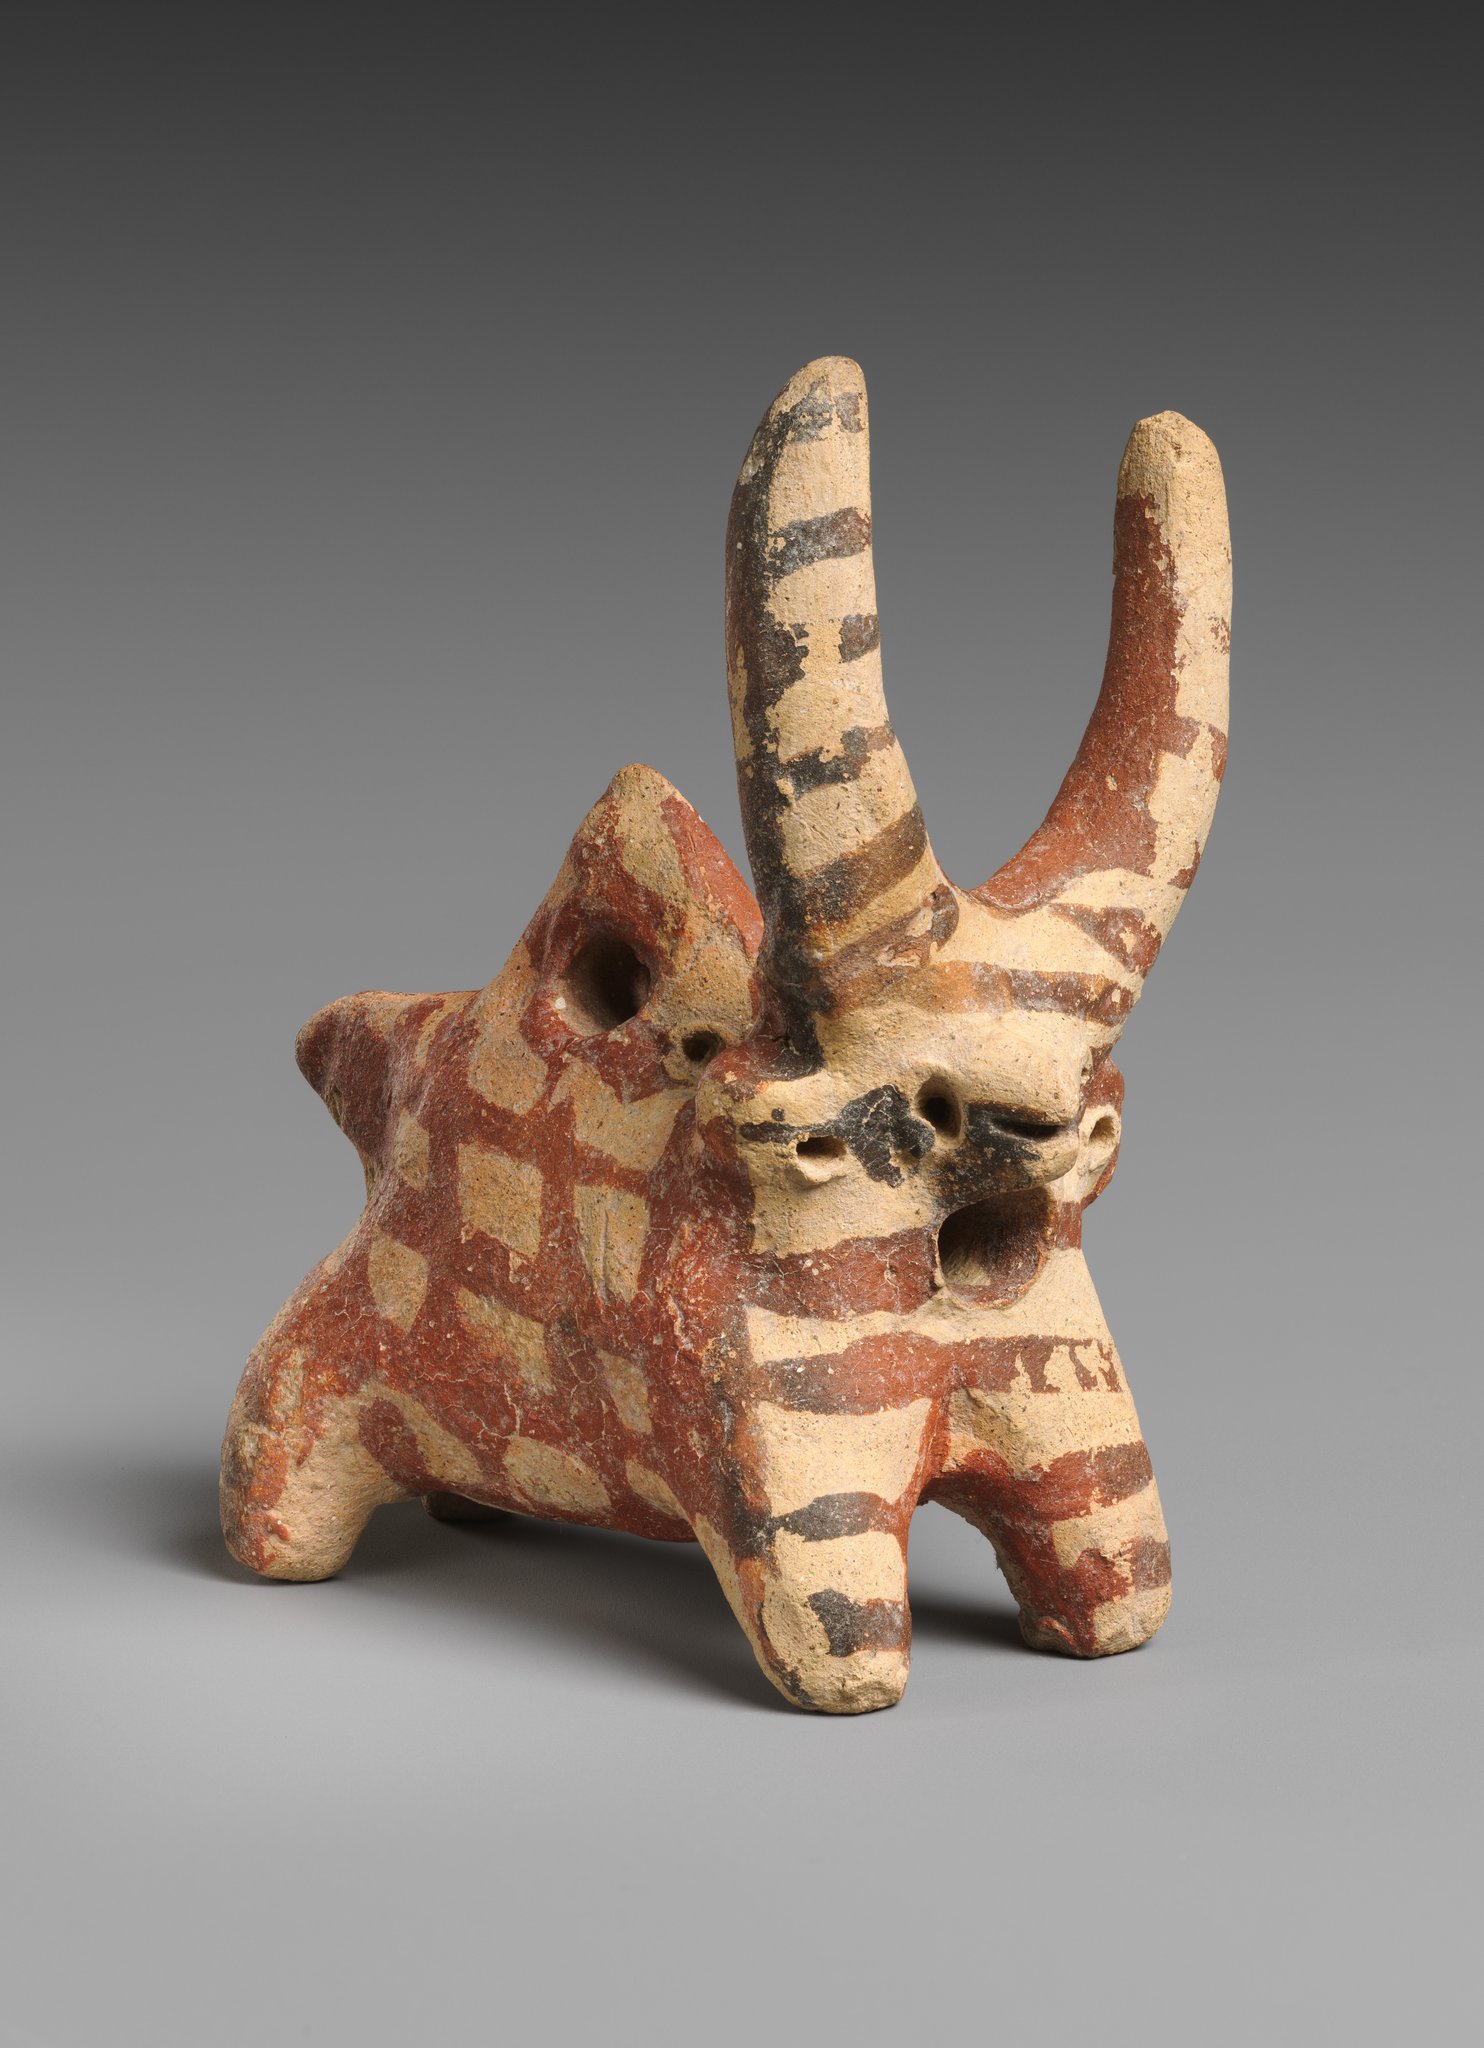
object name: askos in the form of a bull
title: Terracotta askos (vessel) in the form of a bull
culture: cypriot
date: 1800-1600 BCE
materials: terracotta